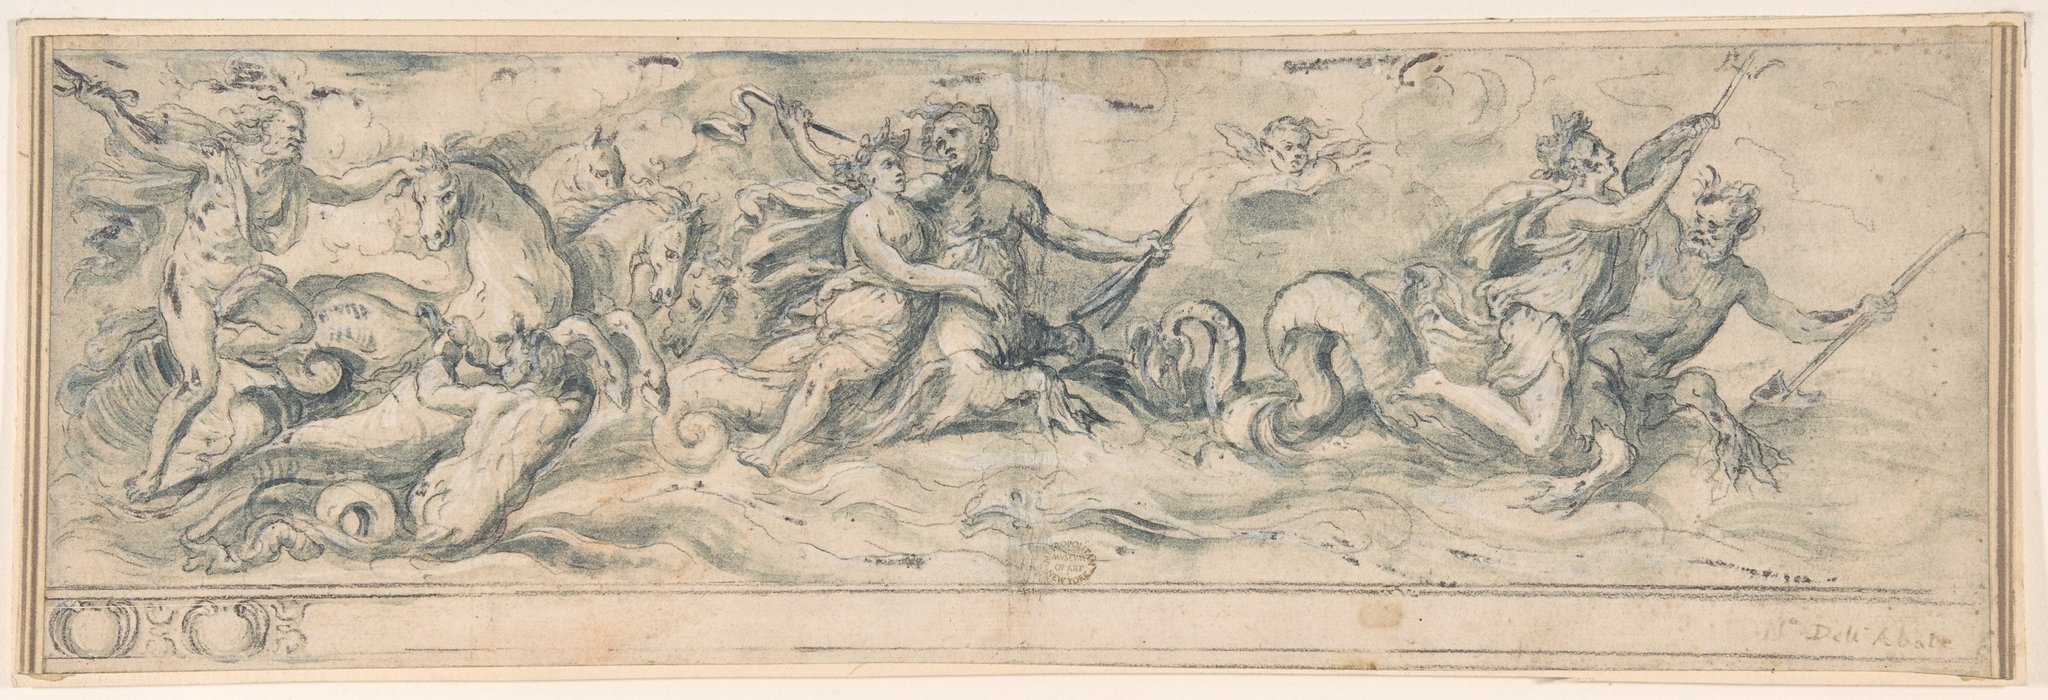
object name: drawing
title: Sea Deities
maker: anonymous, italian, roman-bolognese, 17th century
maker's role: artist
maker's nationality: italian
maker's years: 1600-1700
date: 1601-1700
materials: chalk, gouache, paper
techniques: brush, highlighting, wash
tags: men,mythical creatures,horses